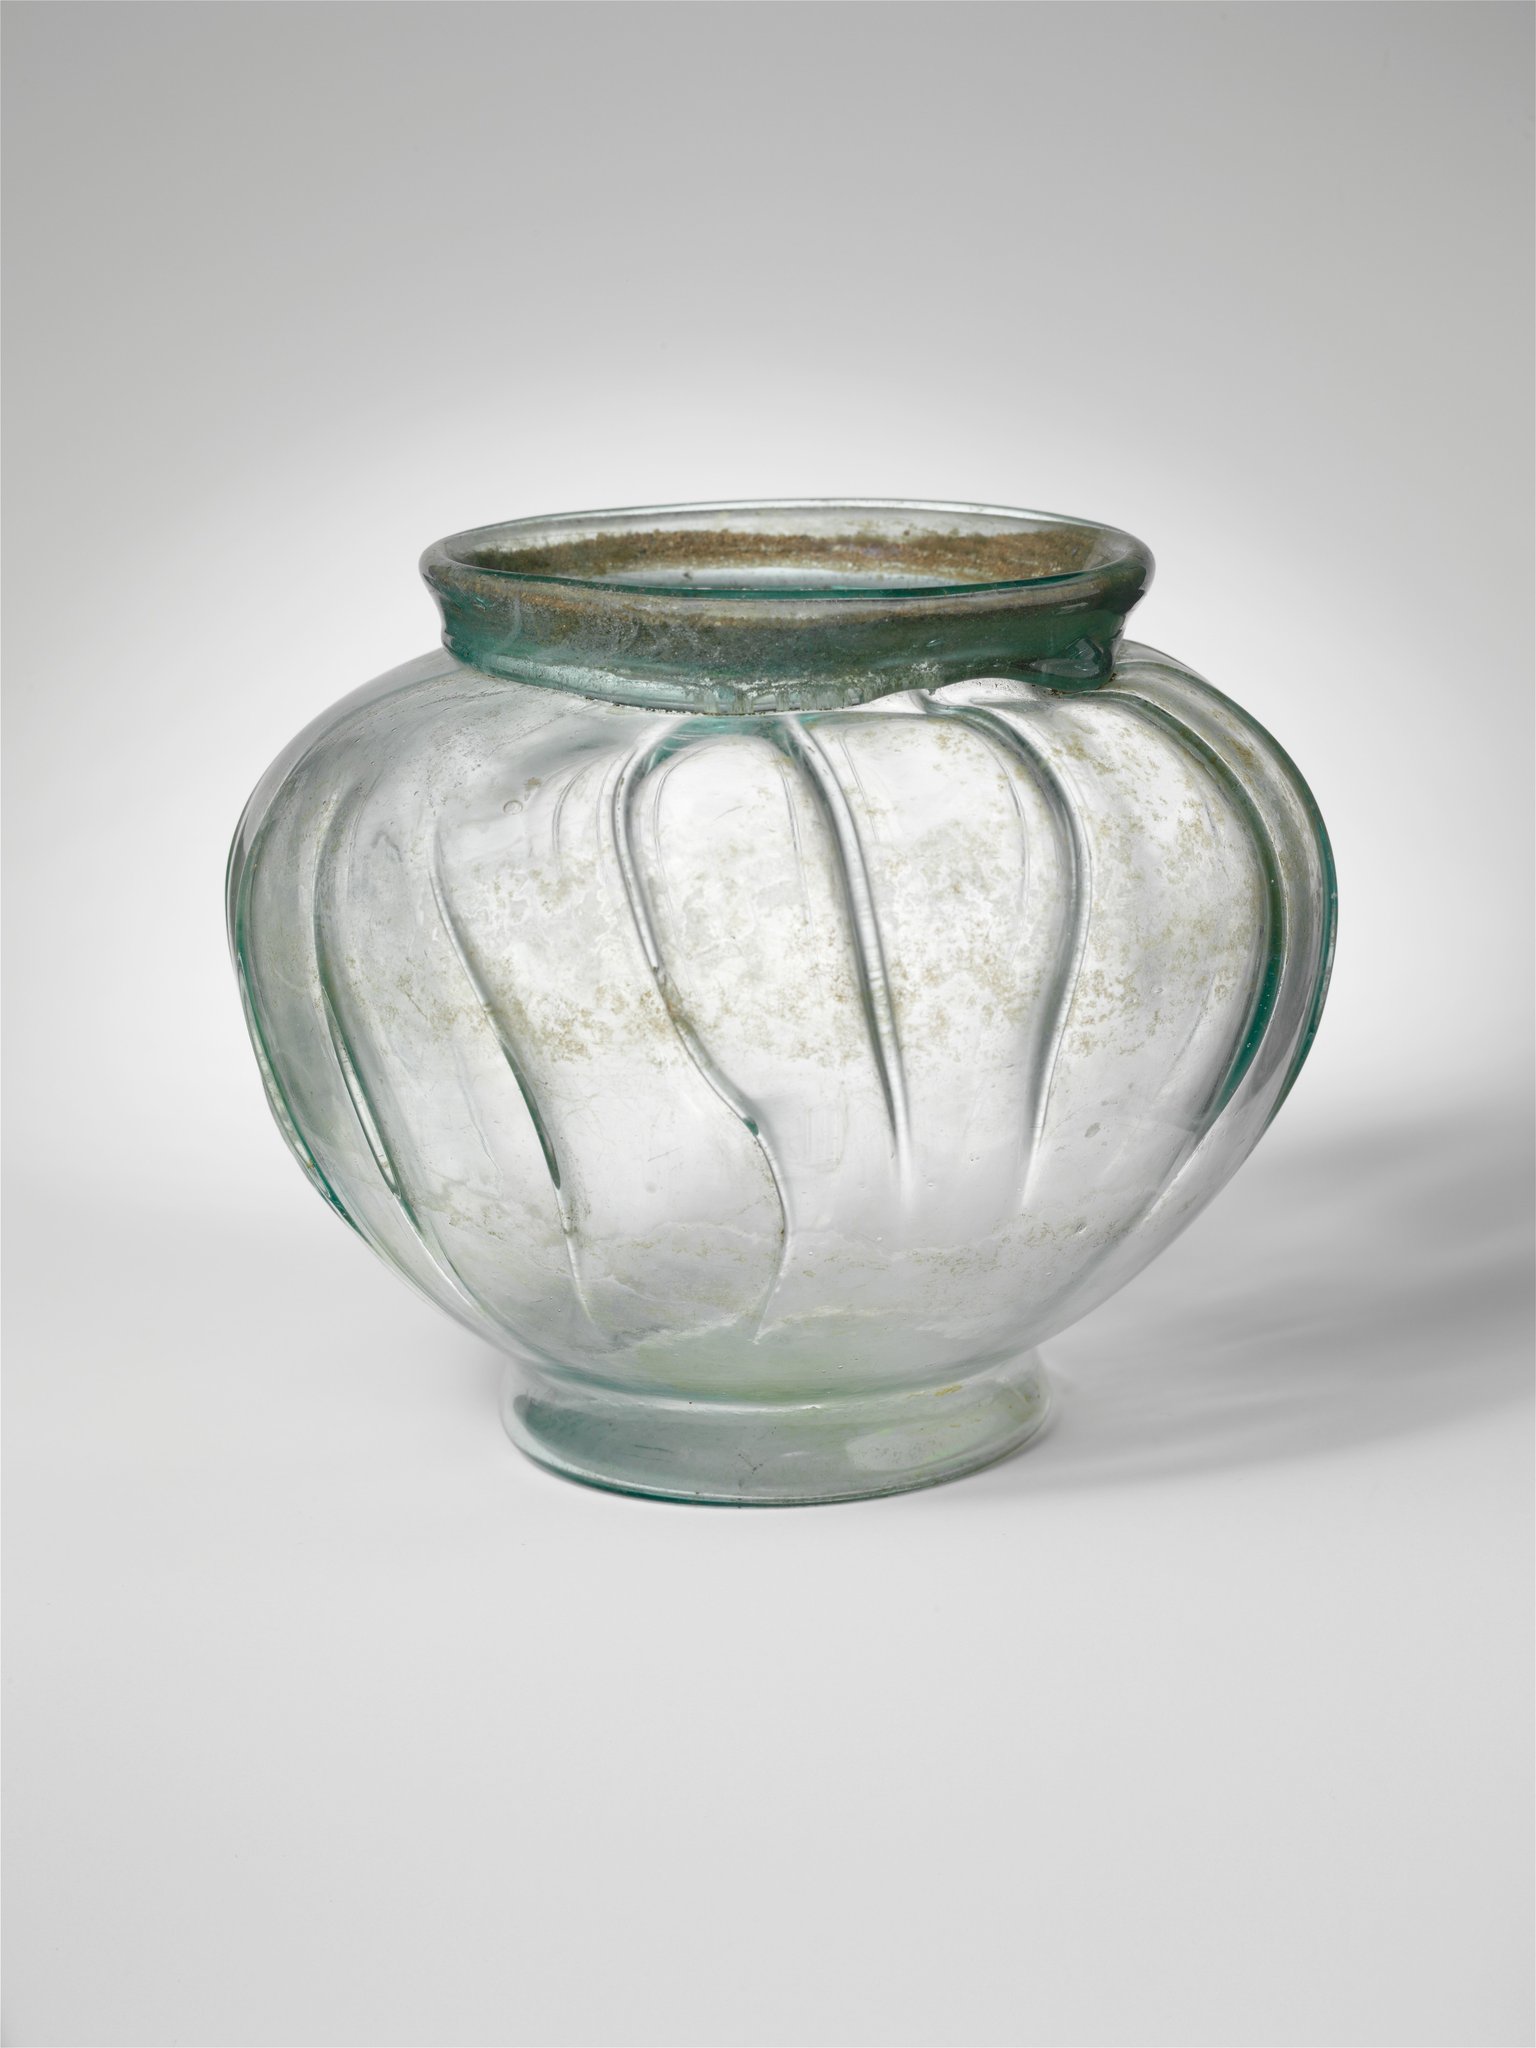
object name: jar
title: Glass jar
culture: roman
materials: glass